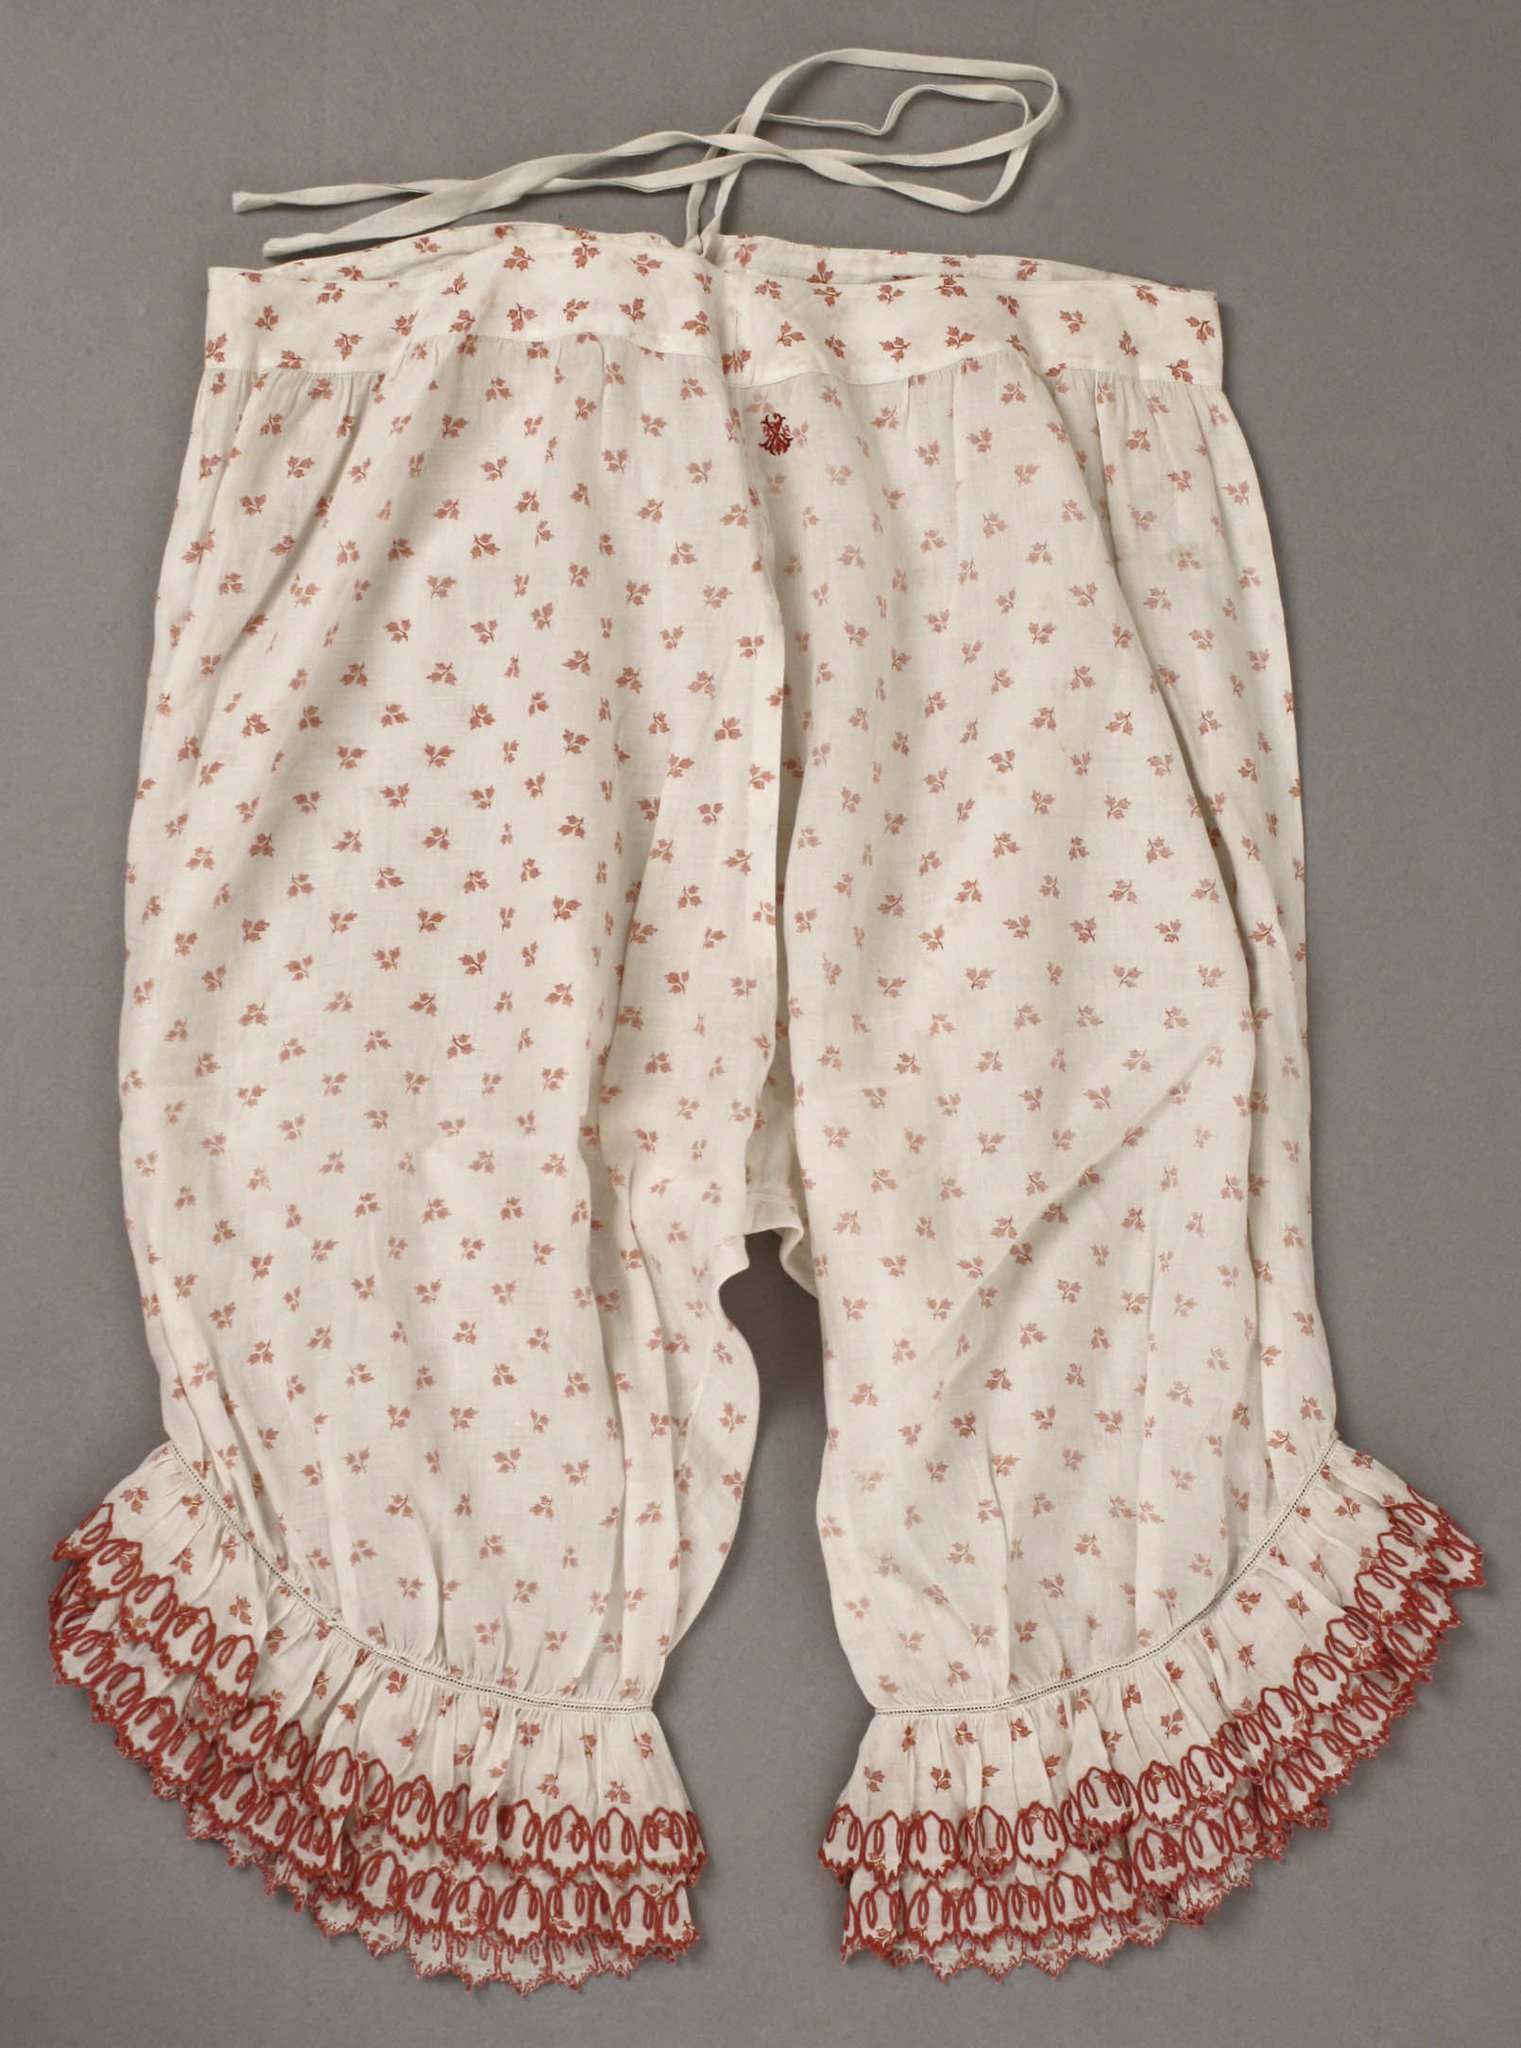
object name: pantalets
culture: american or european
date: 1834-1866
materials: cotton